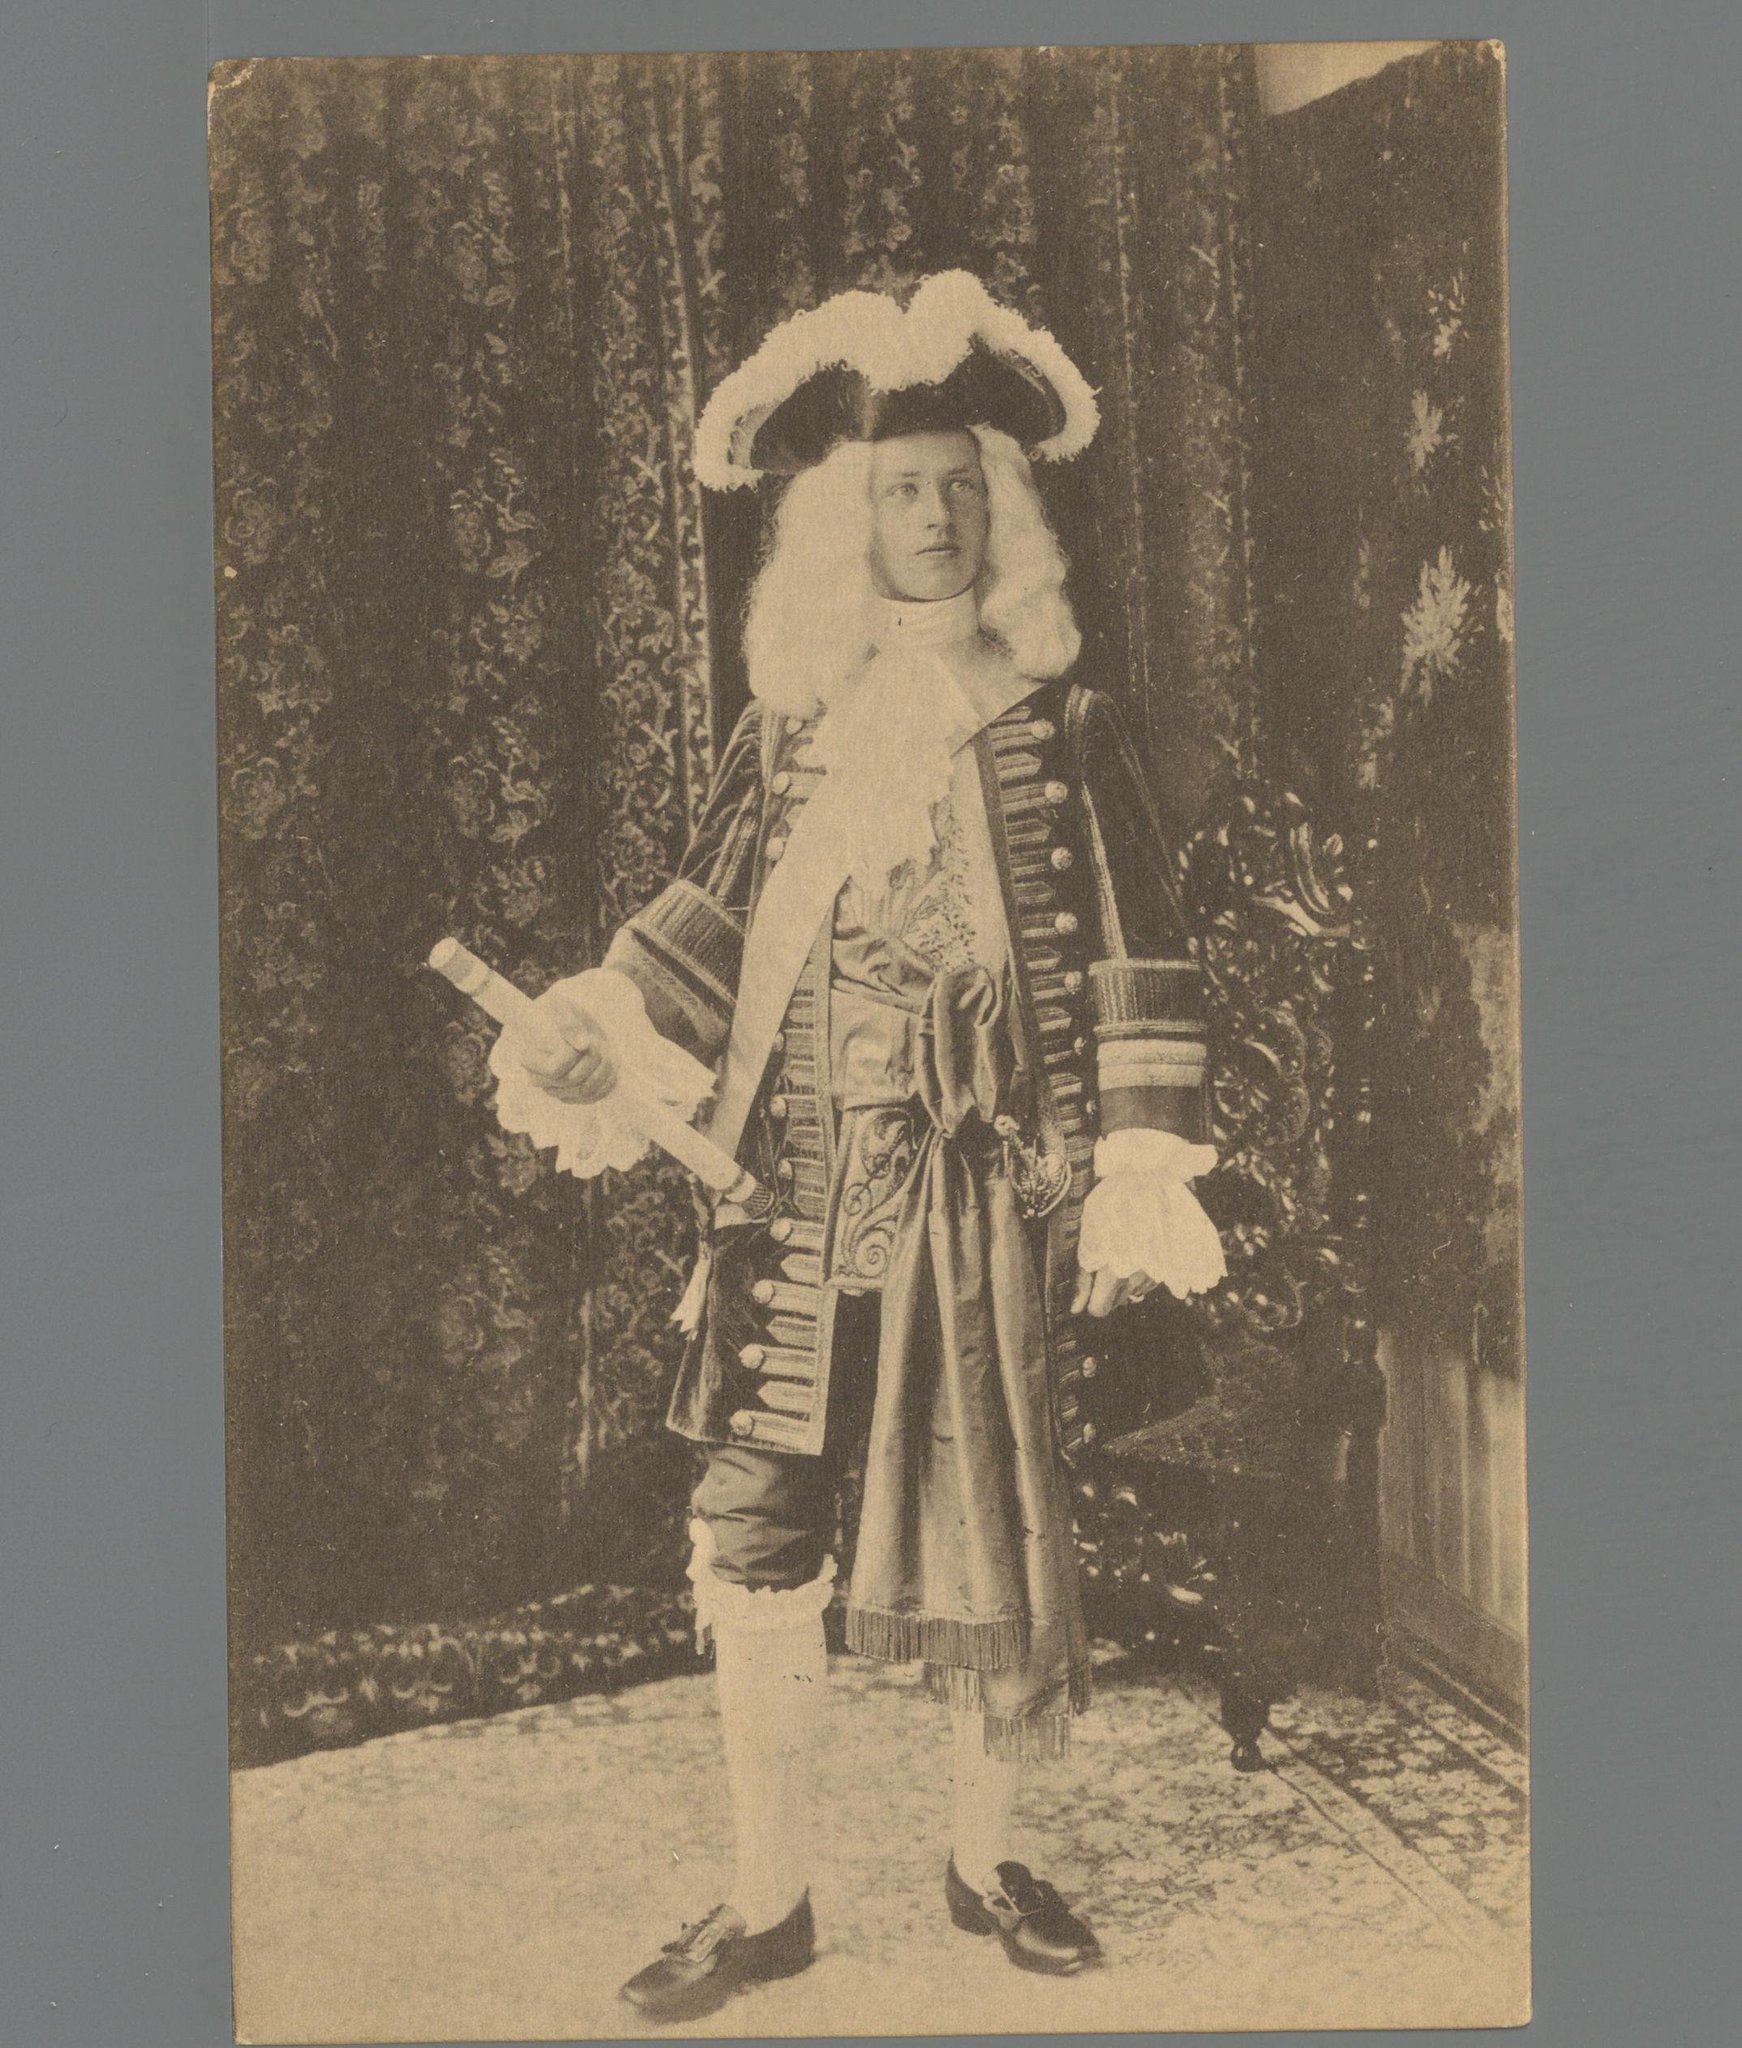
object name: photomechanical print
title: Willem Carel Hendrik Friso, Prins v. Oranje-Nassau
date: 1905-1909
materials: cardboard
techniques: photograph, writing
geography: haarlem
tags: dress-up party, masquerade, masked ball, commemoration, jubilee, leiden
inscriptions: postage stamp